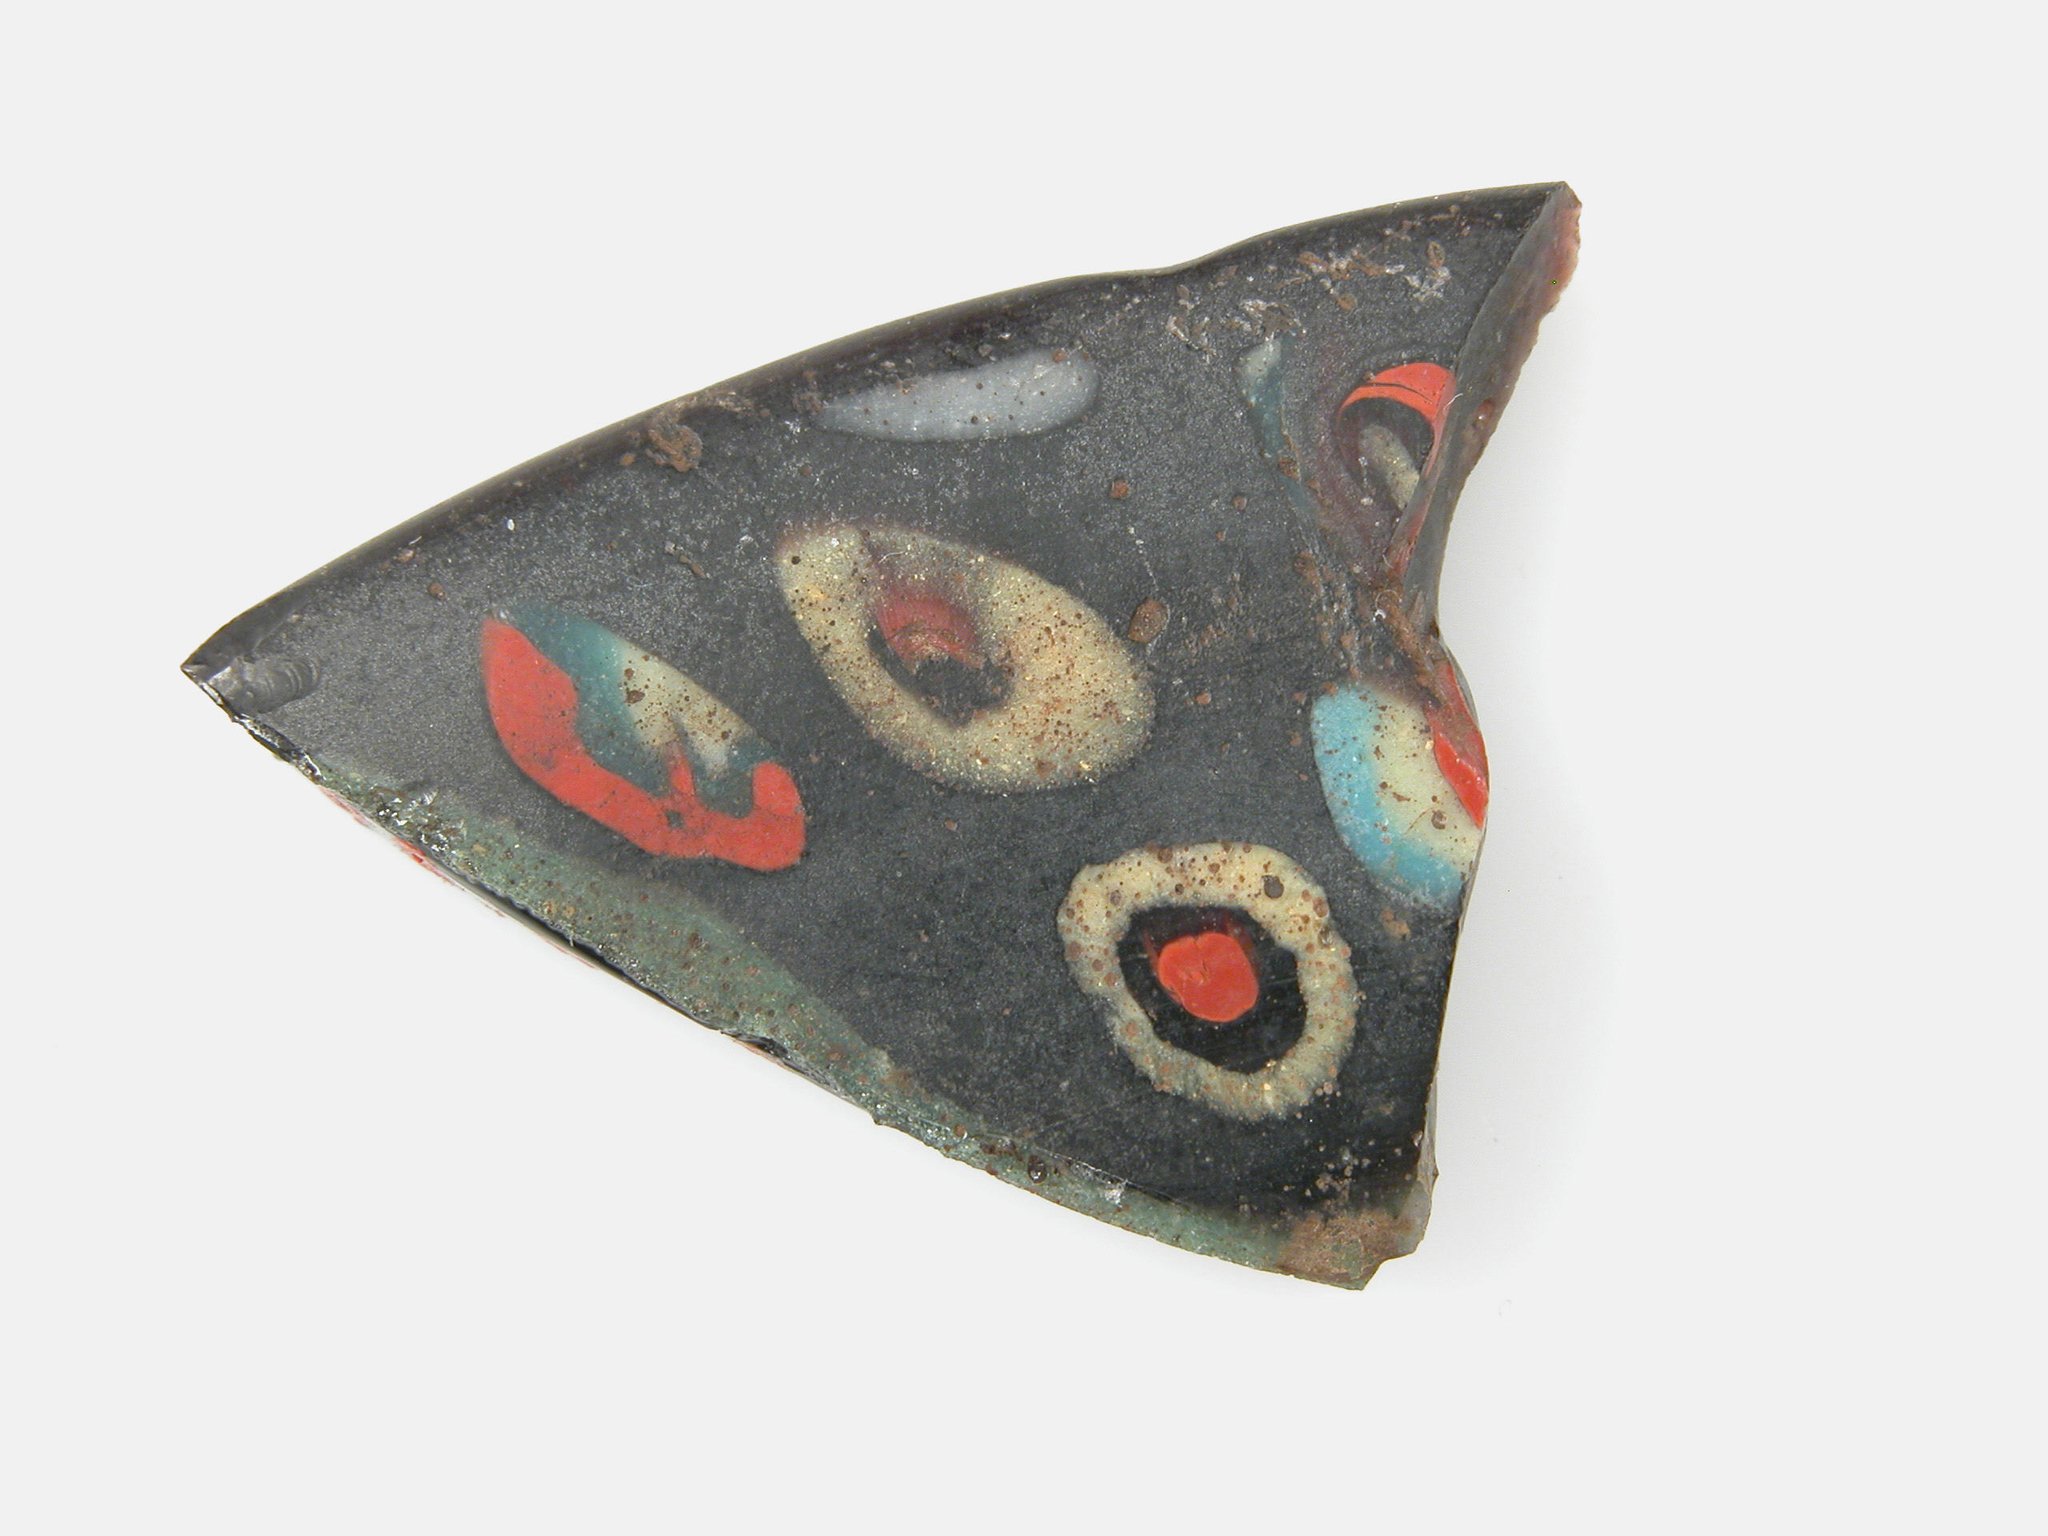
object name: fragment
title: Glass Fragment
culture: coptic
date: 301-433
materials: glass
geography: egypt